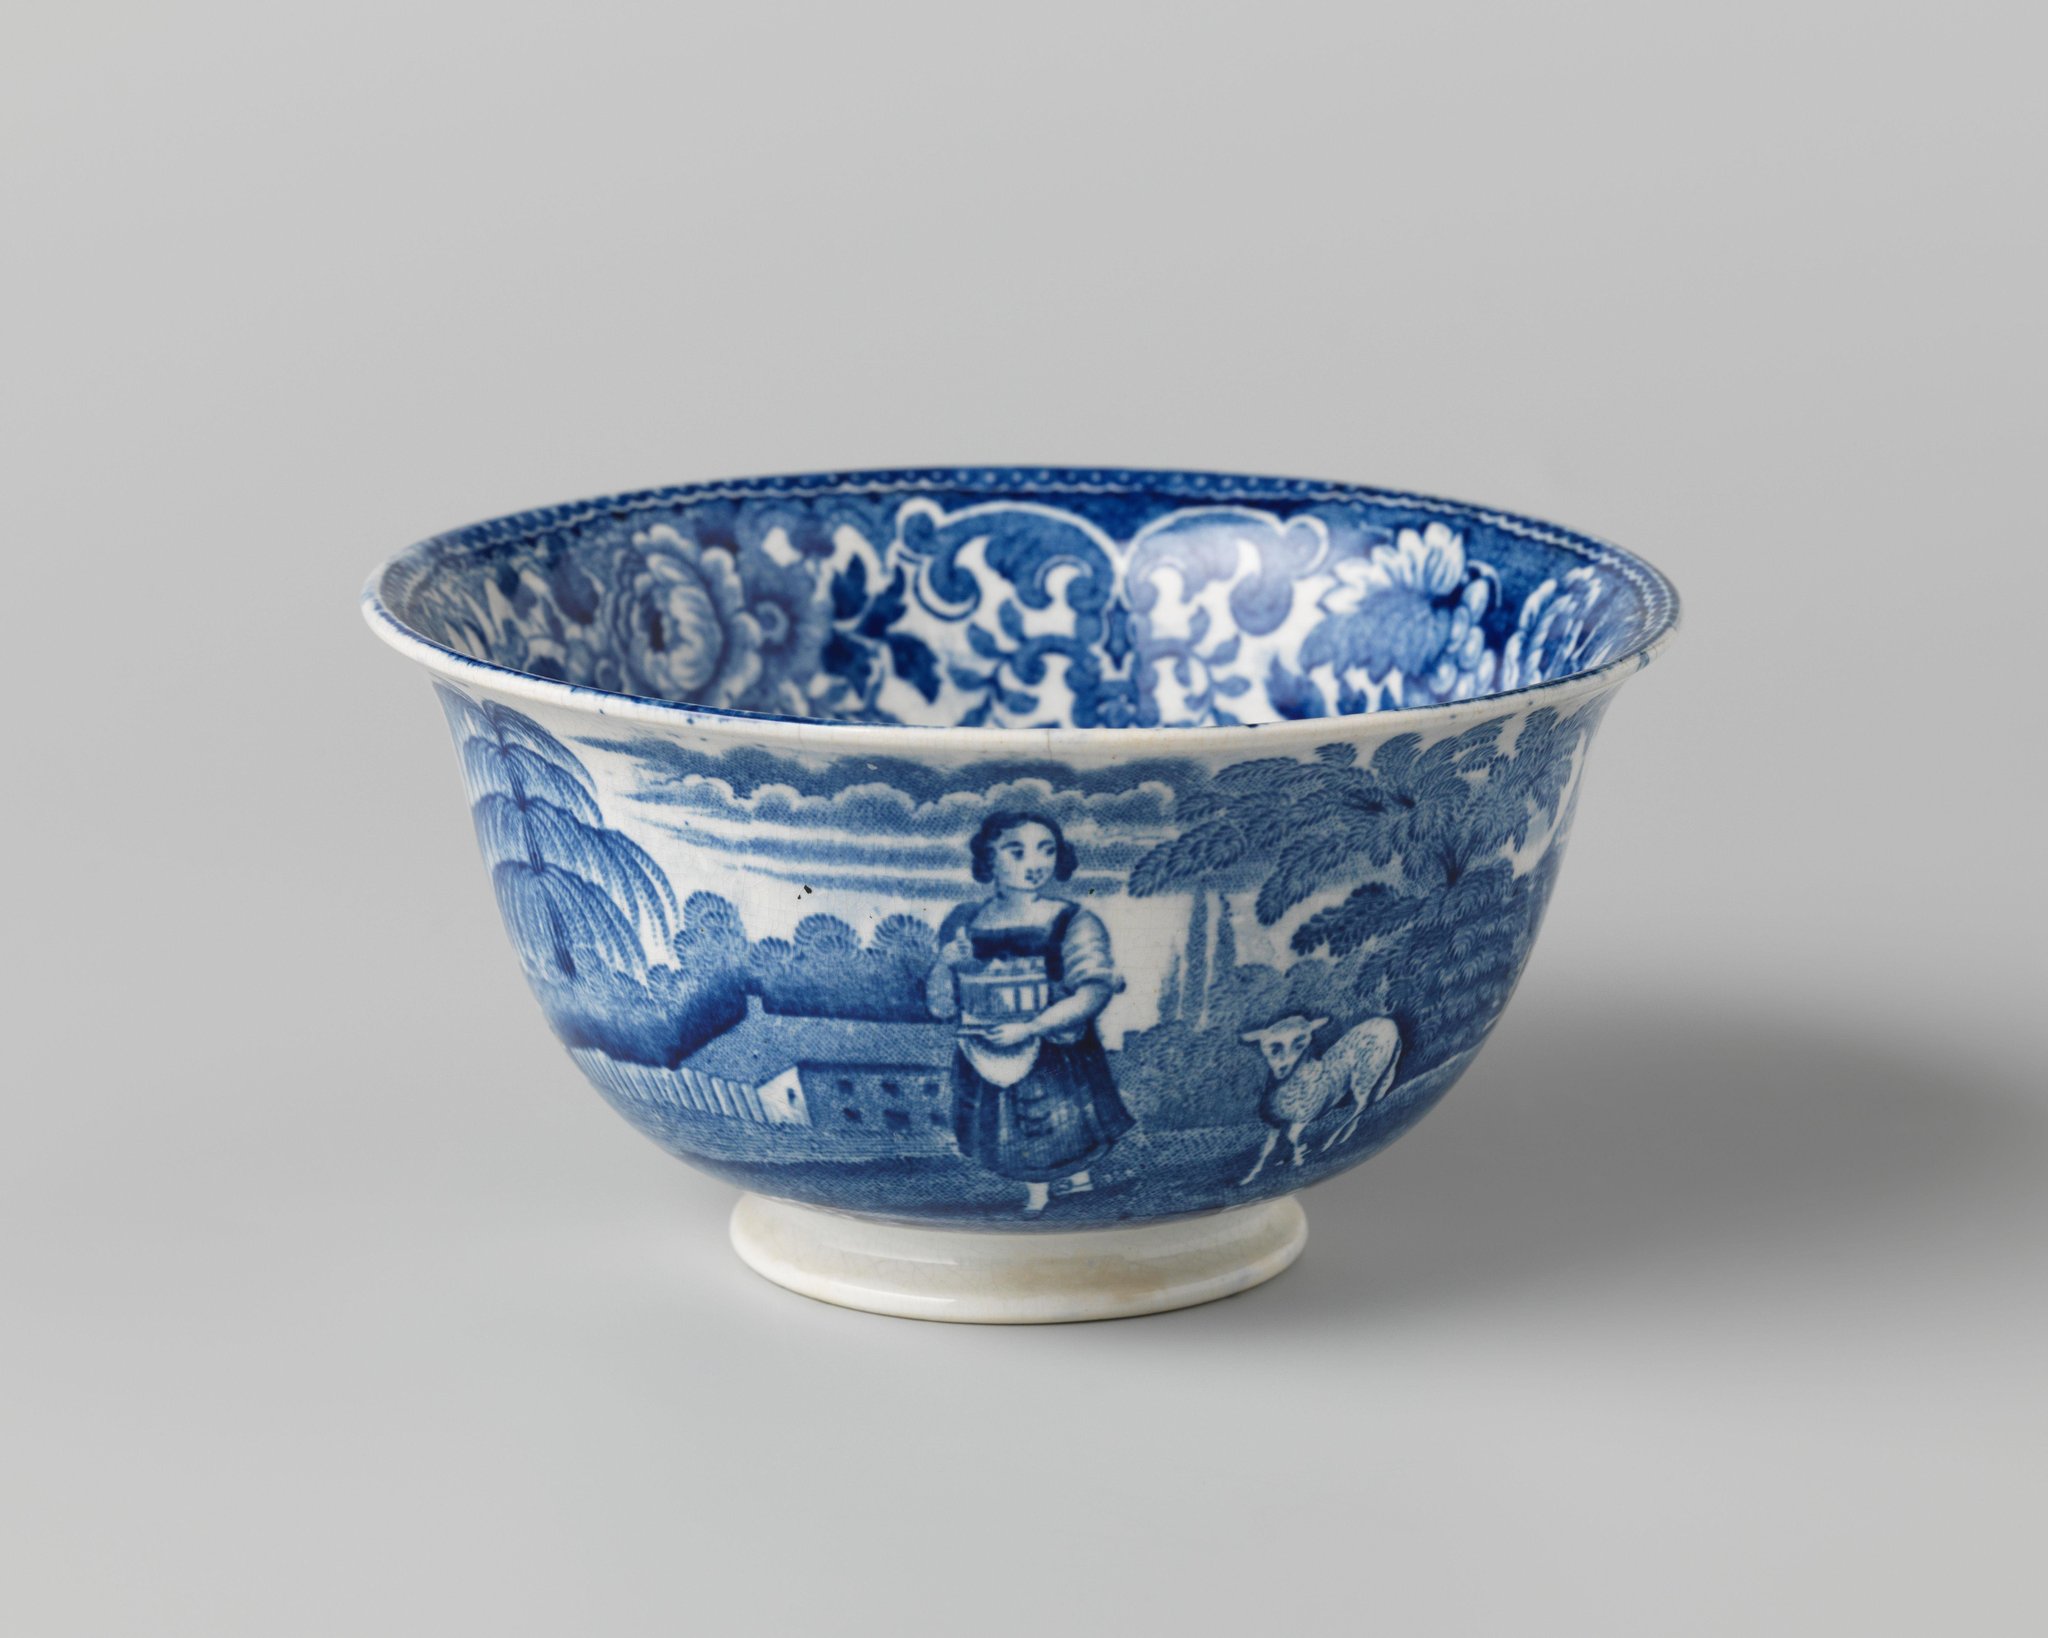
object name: bowl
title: Kom, met decor van een vrouw en een lam in een landschap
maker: nicolaas antoine bosch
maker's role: ceramicist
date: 1853-1867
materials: creamware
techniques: transfer decoration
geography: maastricht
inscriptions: mark: ‘N.B. // 3’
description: Kom van aardewerk met blauw transferdecor. De wand is aan de buitenzijde gedecoreerd met een vrouw en een lam in een landschap. De zelfde voorstelling is aangebracht op de bodem van de kom. De binnenzijde van de wand is voorzien van een band met bloemen en bladeren.